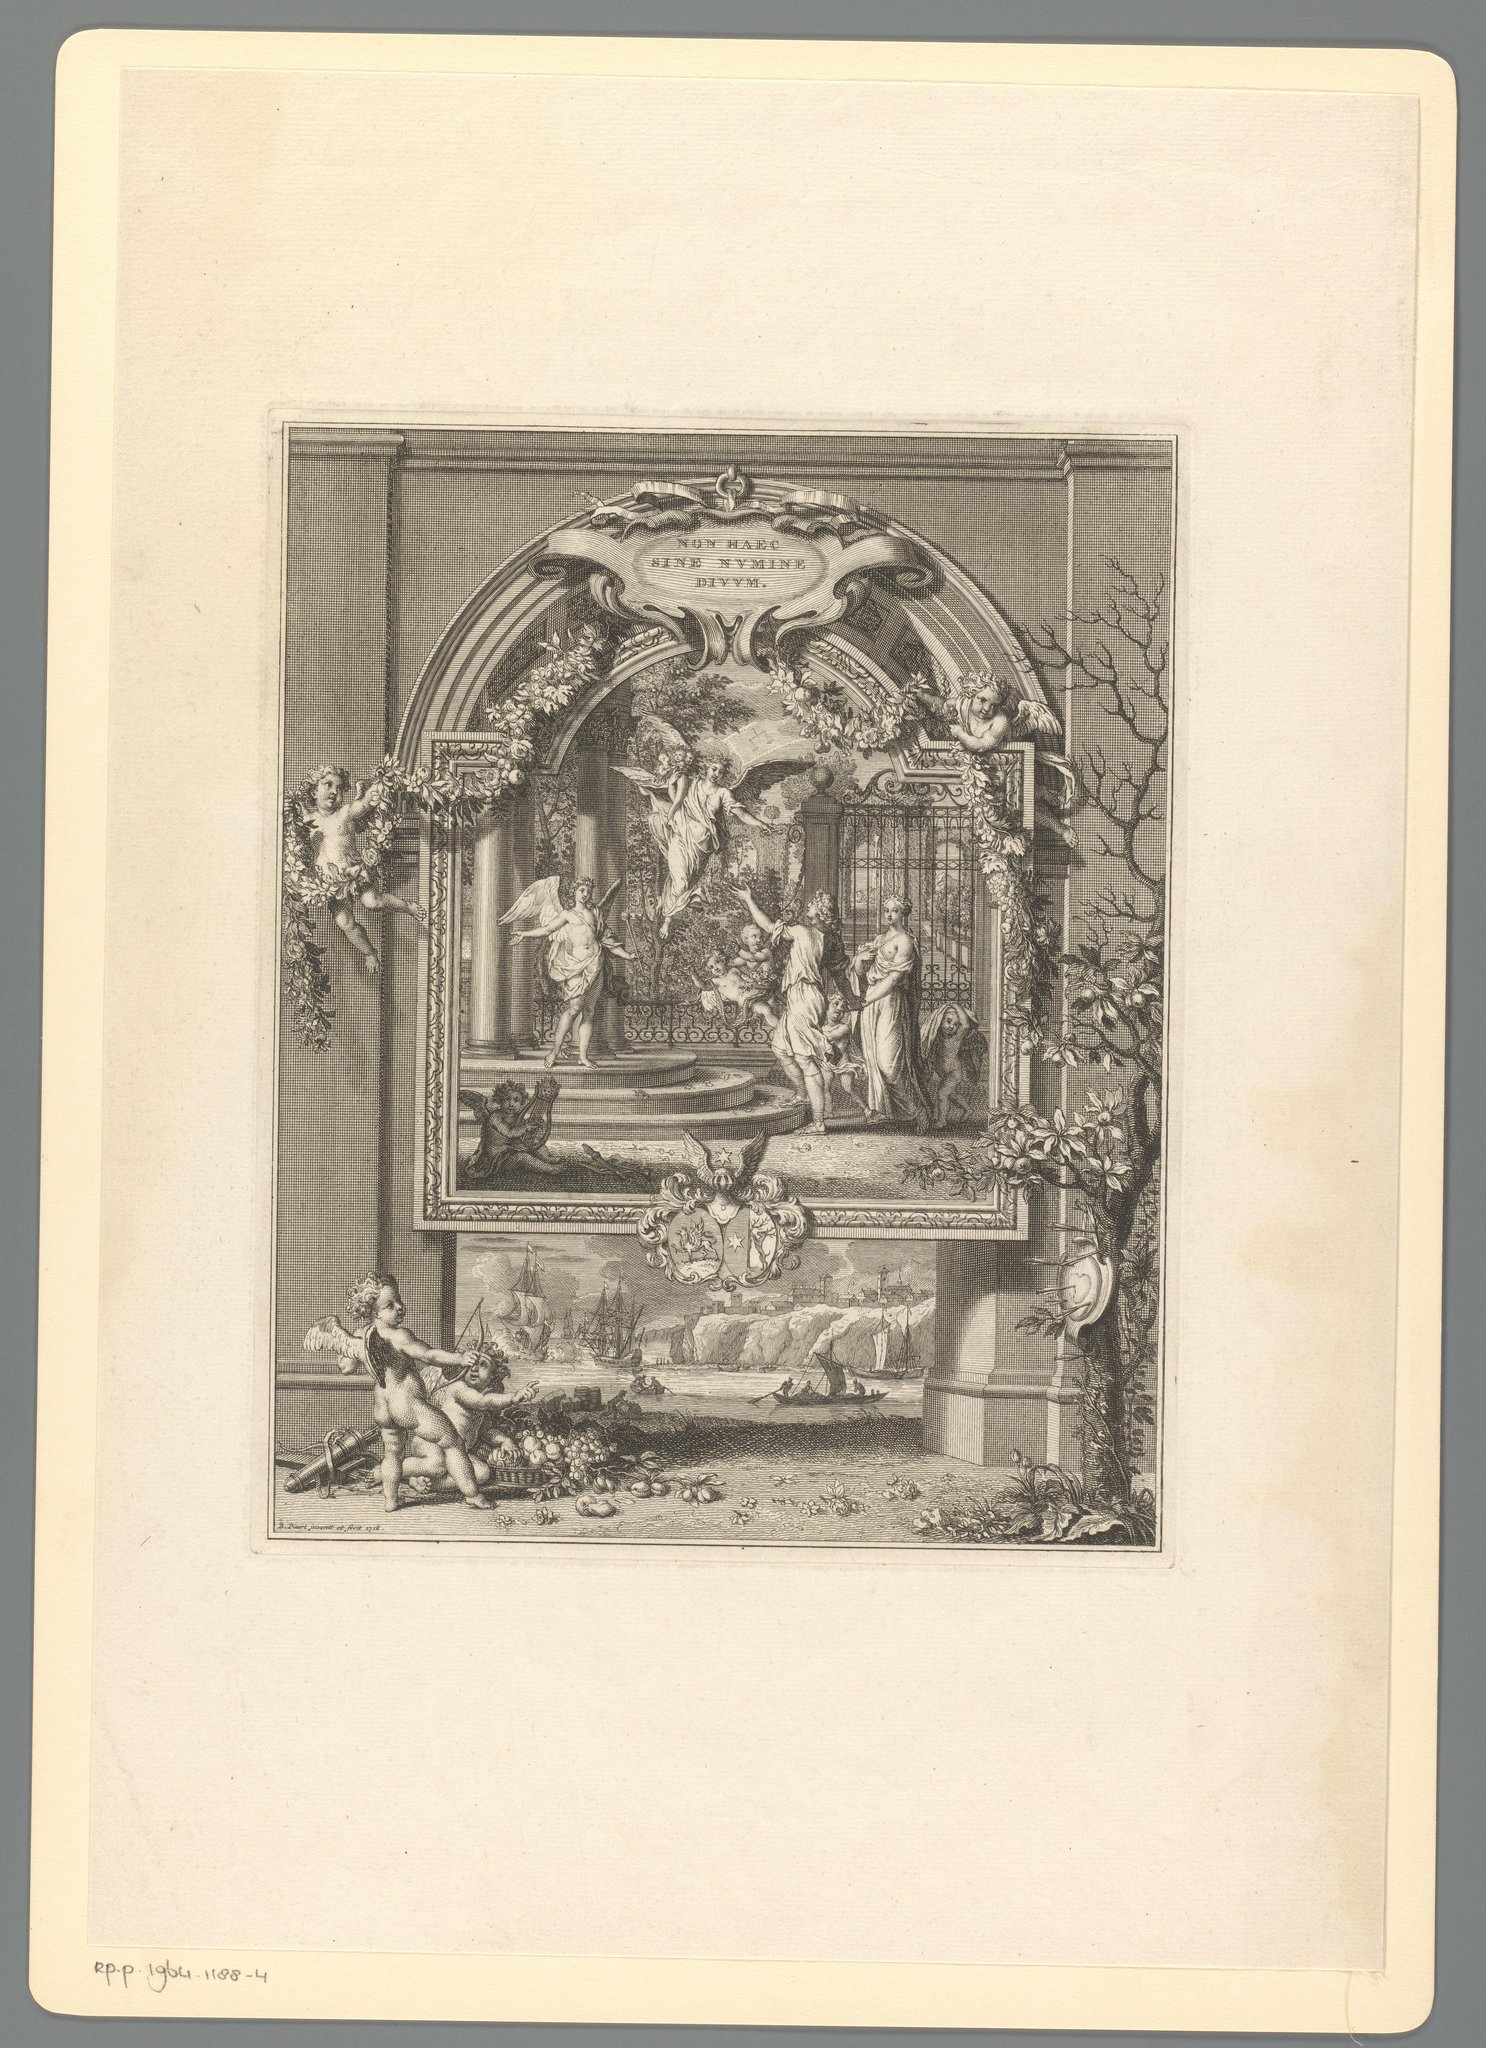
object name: marriage print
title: Allegorische voorstelling ter gelegenheid van het huwelijk van Abraham Bruyn en Debora van Vollenhove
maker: bernard picart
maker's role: draughtsman, print maker, publisher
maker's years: 1673-1733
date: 1718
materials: paper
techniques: engraving, etching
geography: amsterdam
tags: (story of) hymen(aeus), september; 'settembre' (ripa) (+ with signs or personifications of the planets together with zodiacal signs), betrothal and marriage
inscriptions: date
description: Allegorie op het huwelijk van Abraham Bruyn en Debora van Vollenhove in 1718. Het echtpaar wordt door putti naar de huwelijksgod Hymen geleid. Boven hen zweeft de personificatie van de maand september met een sleutel in de ene hand en een hoorn des overvloeds gevuld met kindertjes in de andere hand. De voorstelling is gevat in een lijst met midden onder de wapenschilden van de echtgenoten. Midden boven het devies: 'Non haec sine numine divum'. Onder deze voorstelling verwijzen schepen naar hun handel en op het strand schieten putti pijlen.